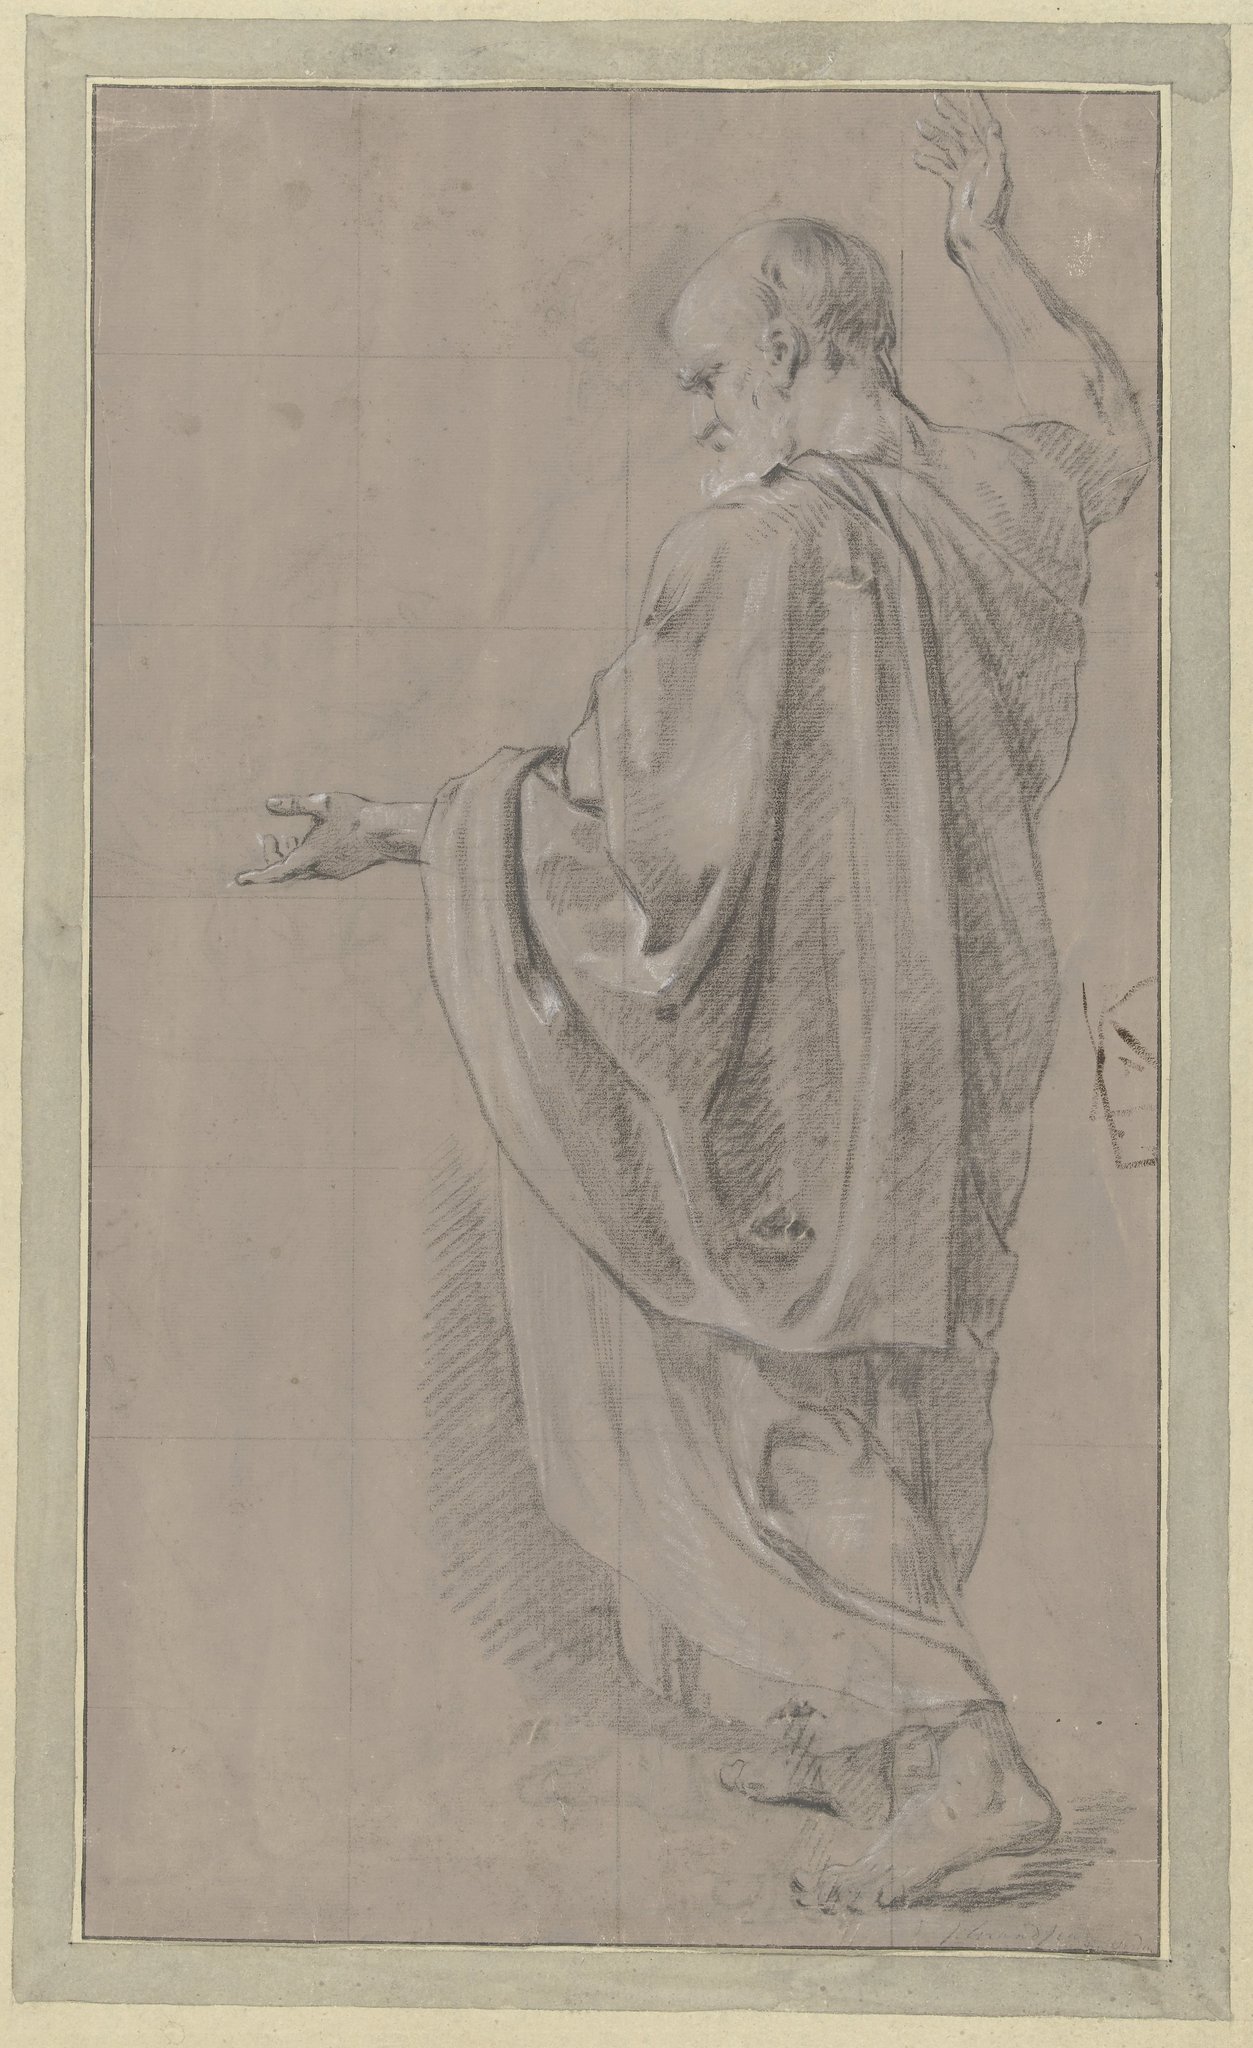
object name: drawing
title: Staande man in toga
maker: jean grandjean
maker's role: draughtsman, print maker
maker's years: 1752-1781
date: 1765-1781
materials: chalk, paper